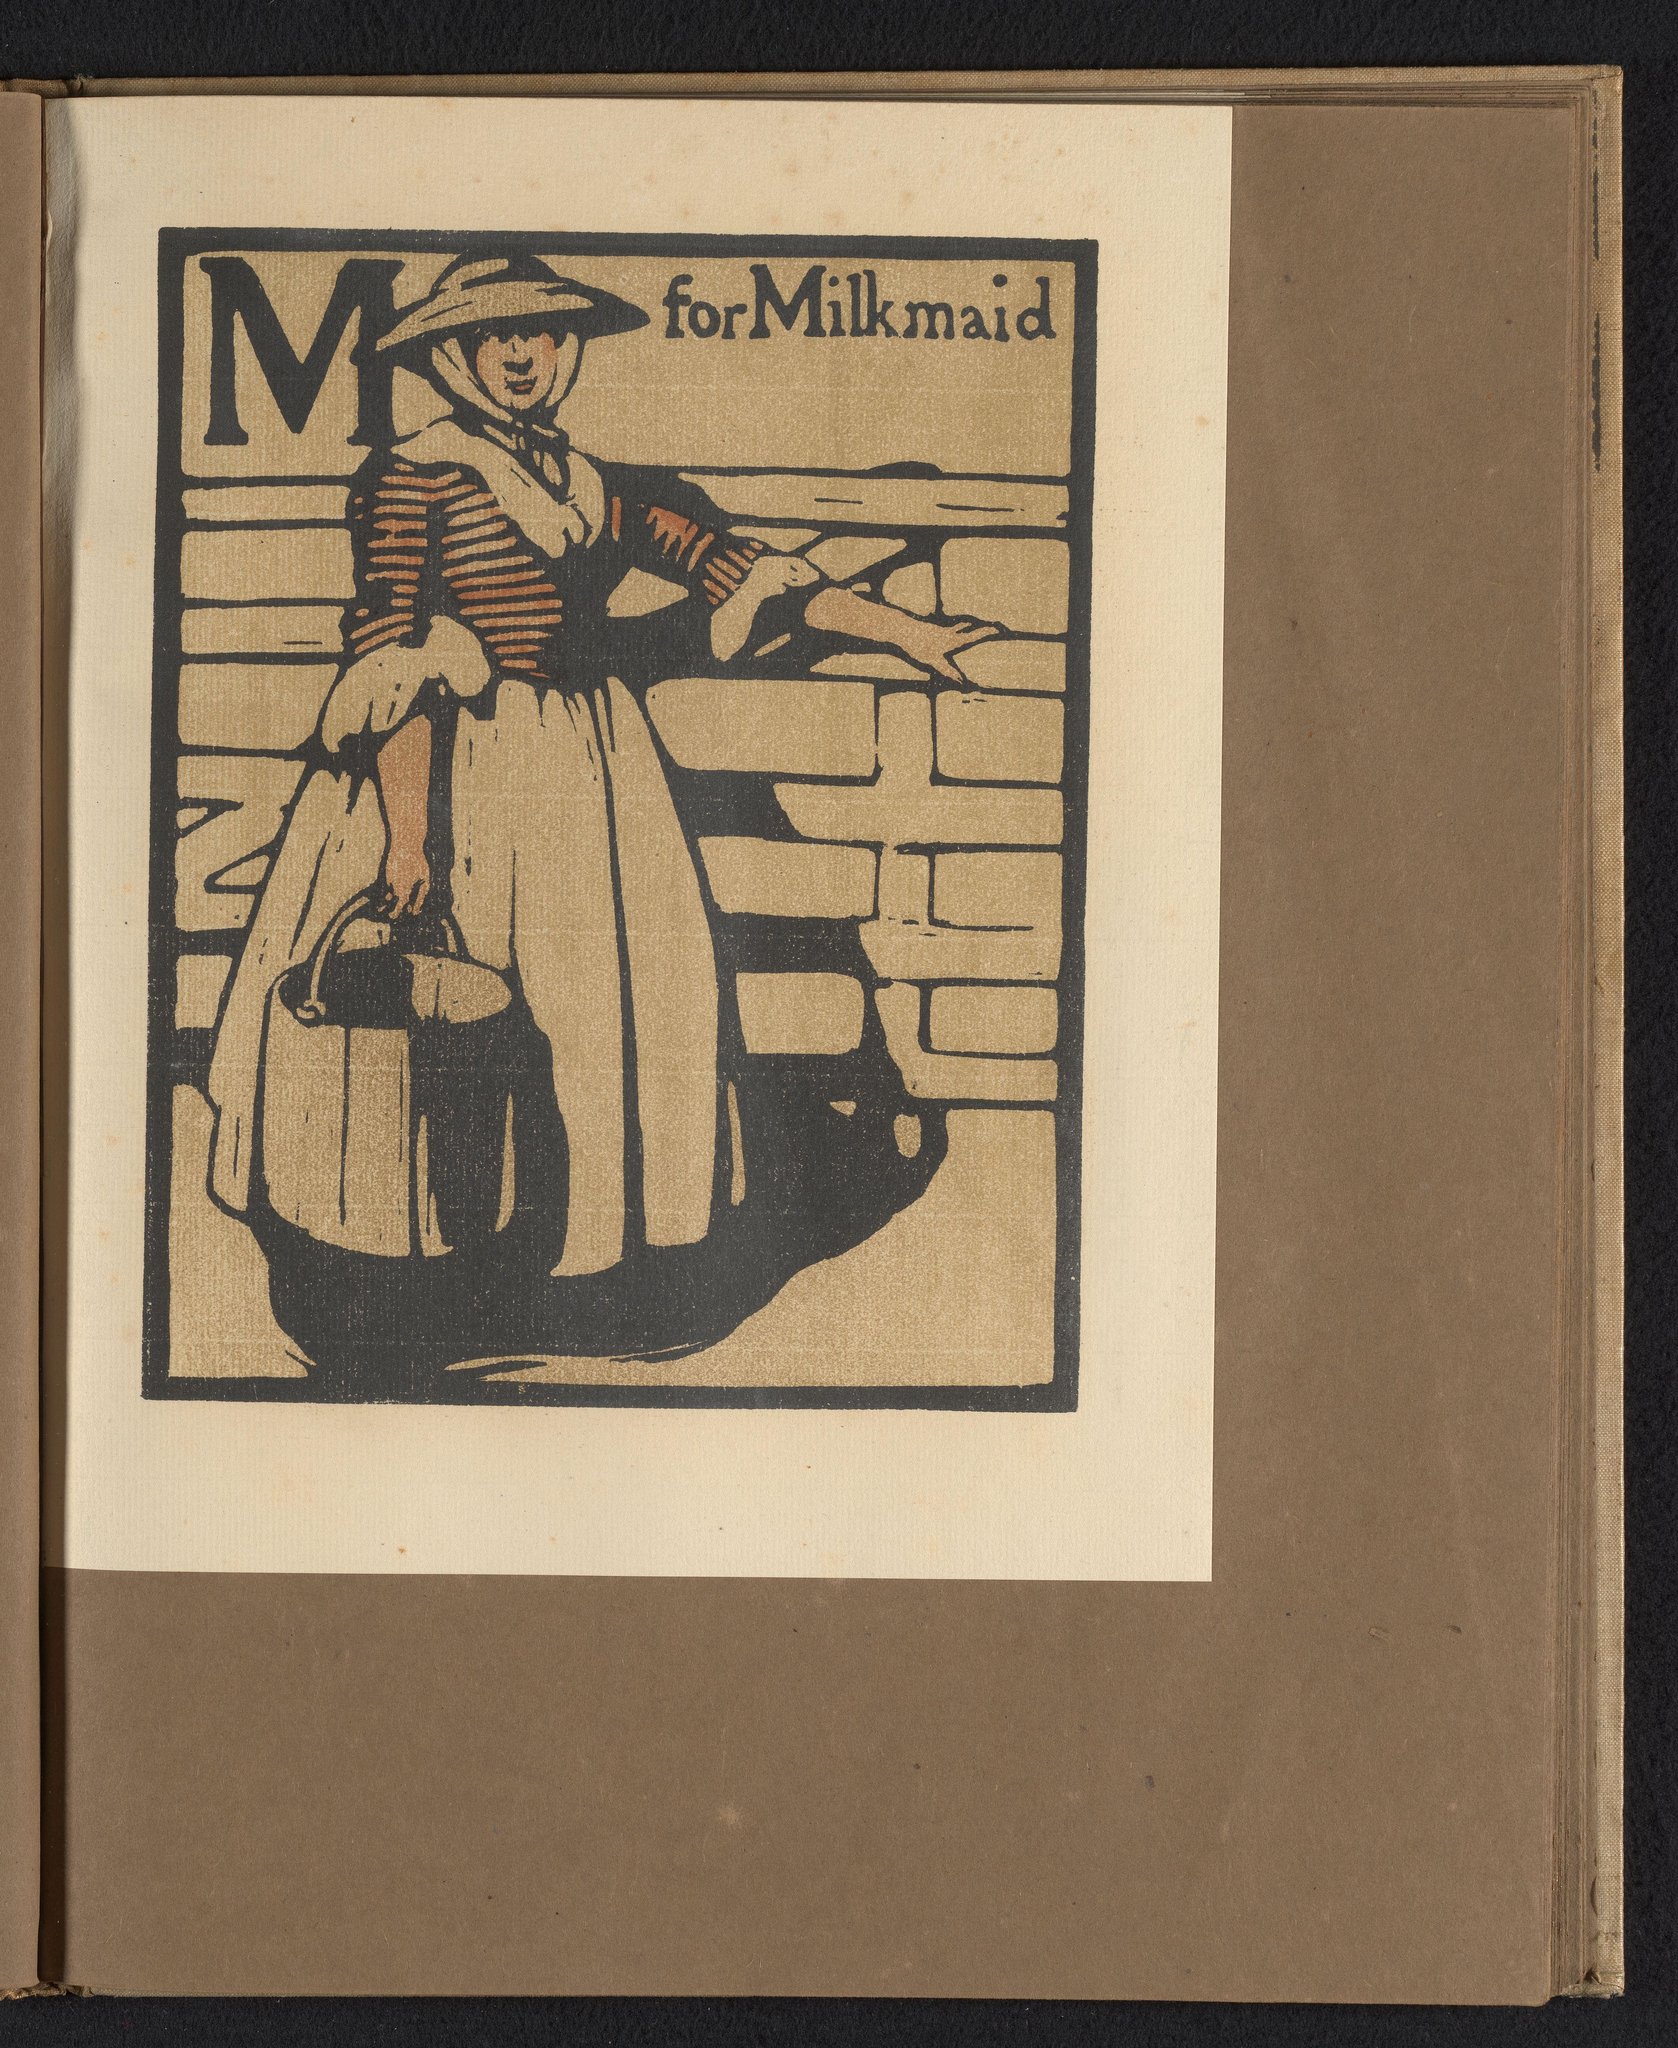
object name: page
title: M for Milkmaid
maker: william heinemann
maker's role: publisher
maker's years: 1863-1920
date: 1898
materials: paper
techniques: lithograph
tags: milkmaid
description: De serie met lithografieën is gemaakt naar ontwerpen van houtsneden door William Nicholson.